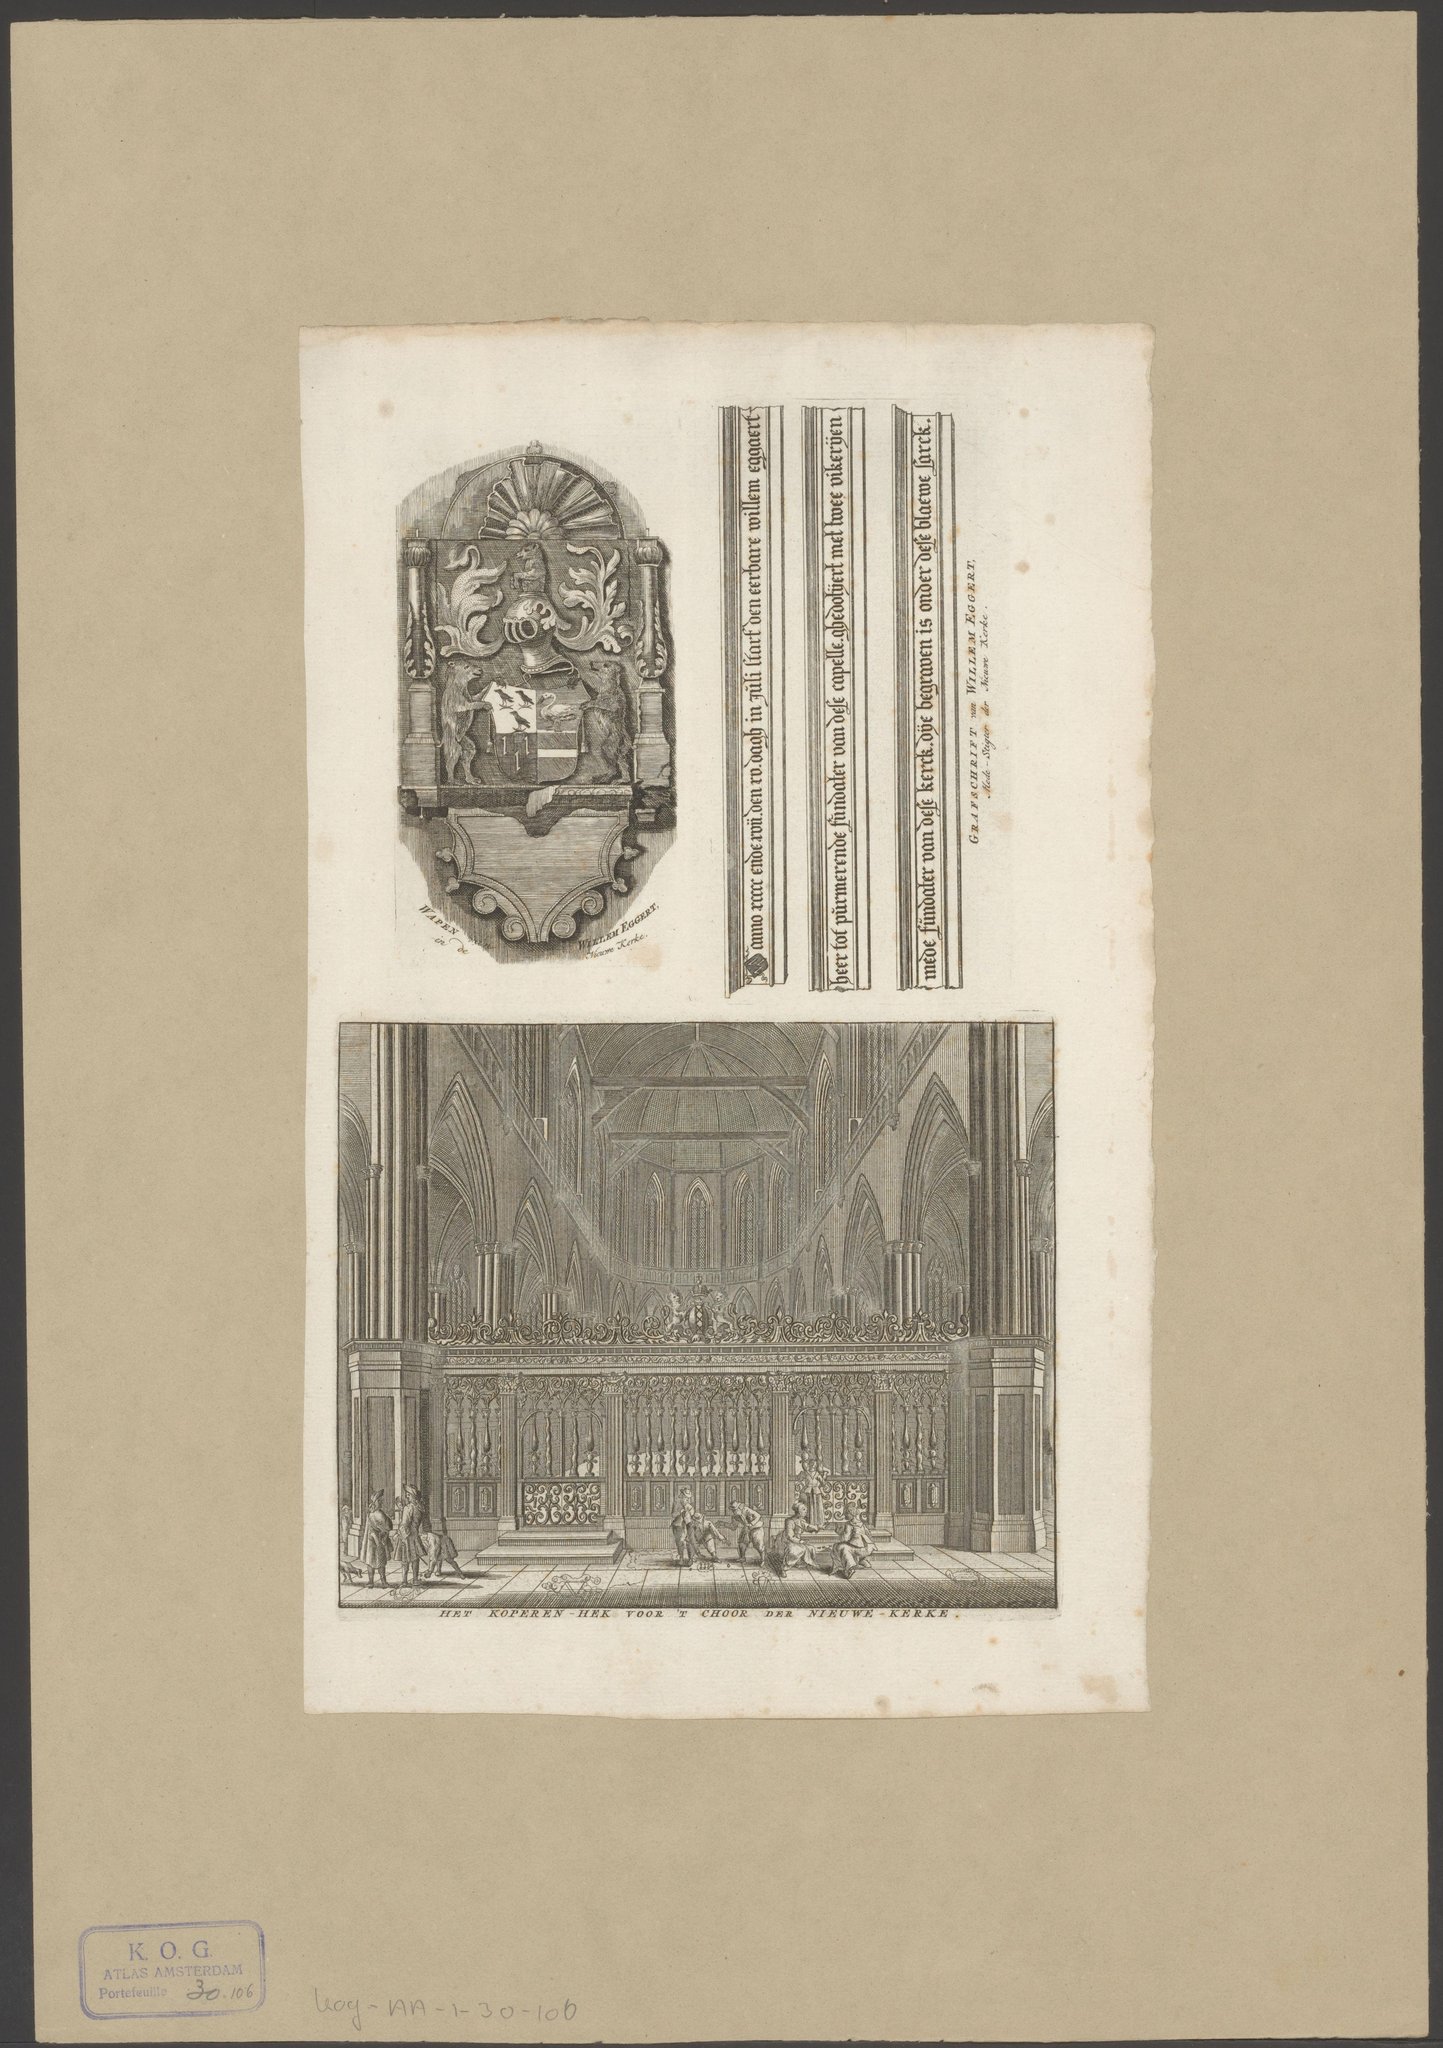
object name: print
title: Wapen en grafschrift van Willem Eggert en interieur van de Nieuwe Kerk te Amsterdam, gezien richting het koor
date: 1765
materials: paper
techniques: engraving, etching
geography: northern netherlands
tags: rood-screen, choir-screen; iconostasis, interior of church, gravestone, tombstone, armorial bearing, heraldry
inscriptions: collector's mark: Lugt 1641b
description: Prent mogelijk uit: Wagenaar, Jan. Amsterdam, in zyne opkomst, aanwas, geschiedenissen (…). Amsterdam: Isaak Tirion, 1765, dl. 2.